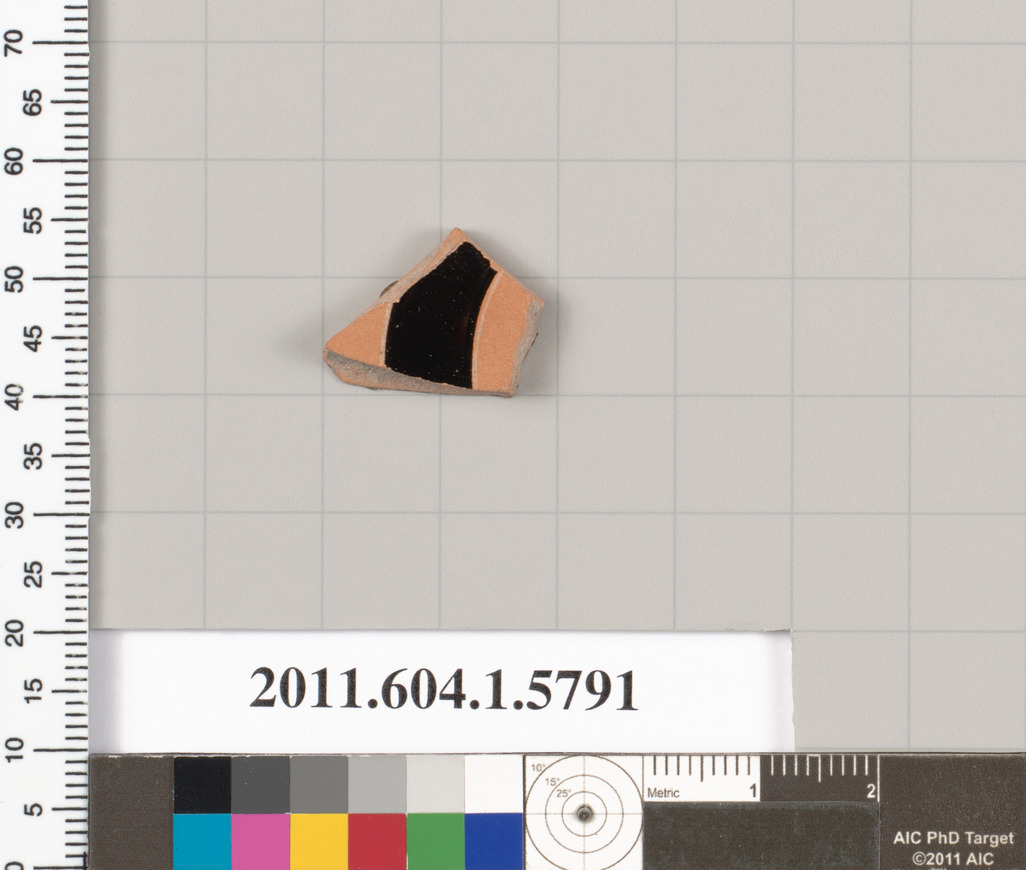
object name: kylix fragment, eye cup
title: Terracotta fragment of a kylix: eye-cup (drinking cup)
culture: greek, attic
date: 520-510 BCE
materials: terracotta